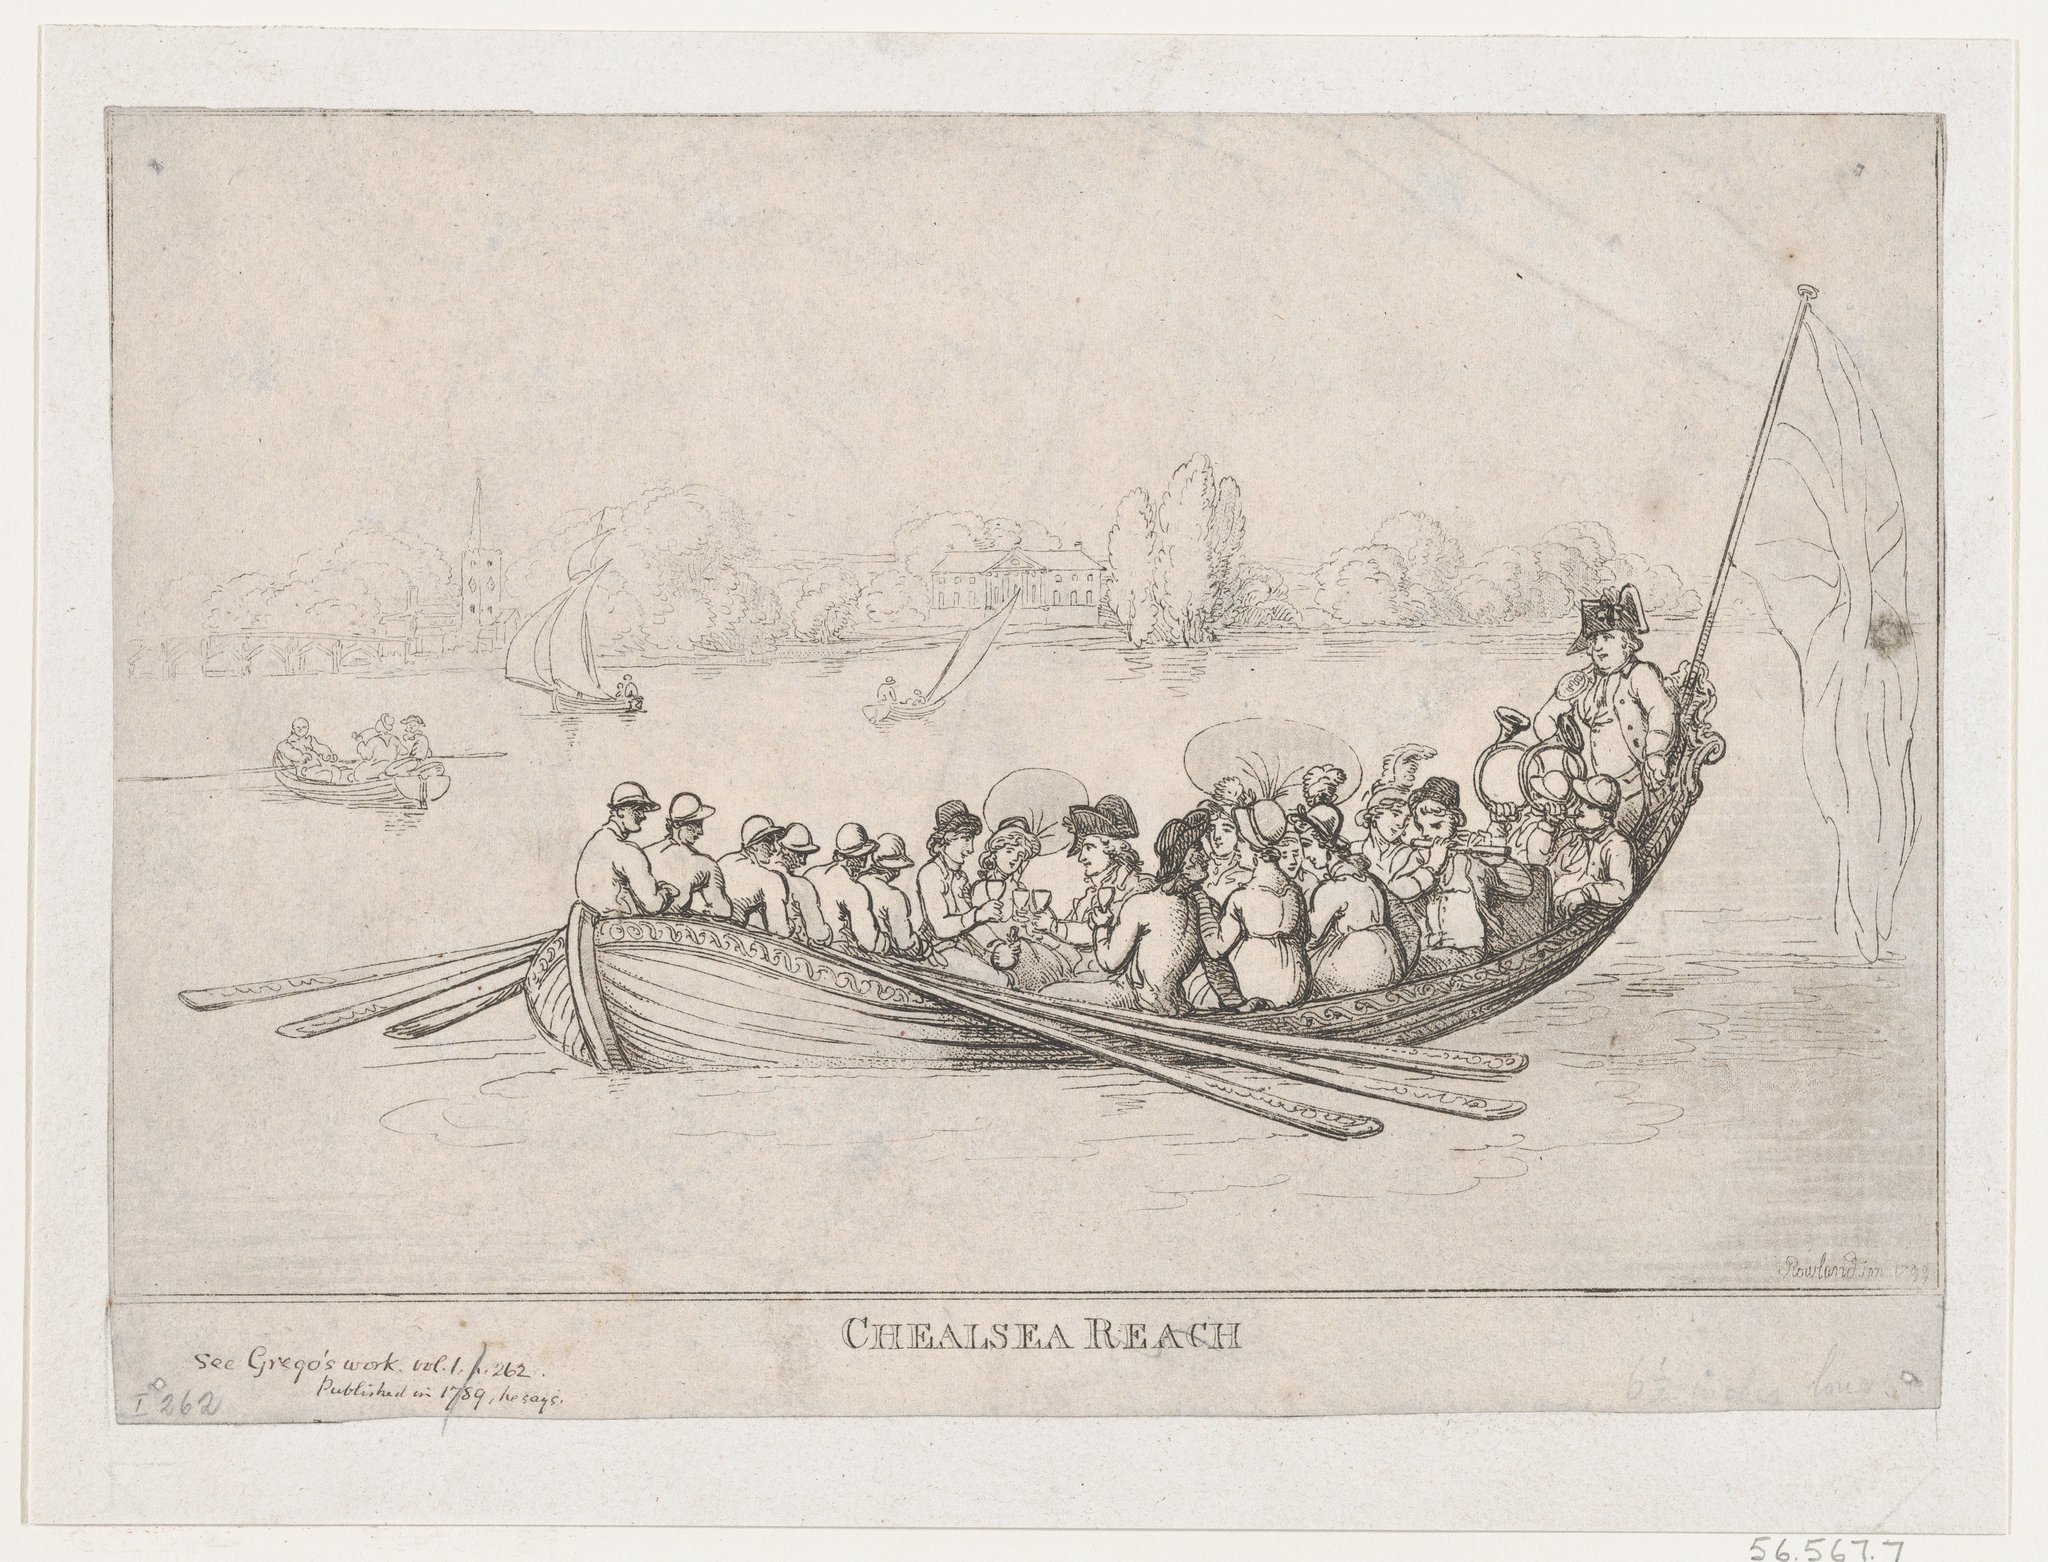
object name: print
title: Chelsea Reach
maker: thomas rowlandson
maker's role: artist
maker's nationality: british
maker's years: 1757-1827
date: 1799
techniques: aquatint, etching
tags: human figures,rowing